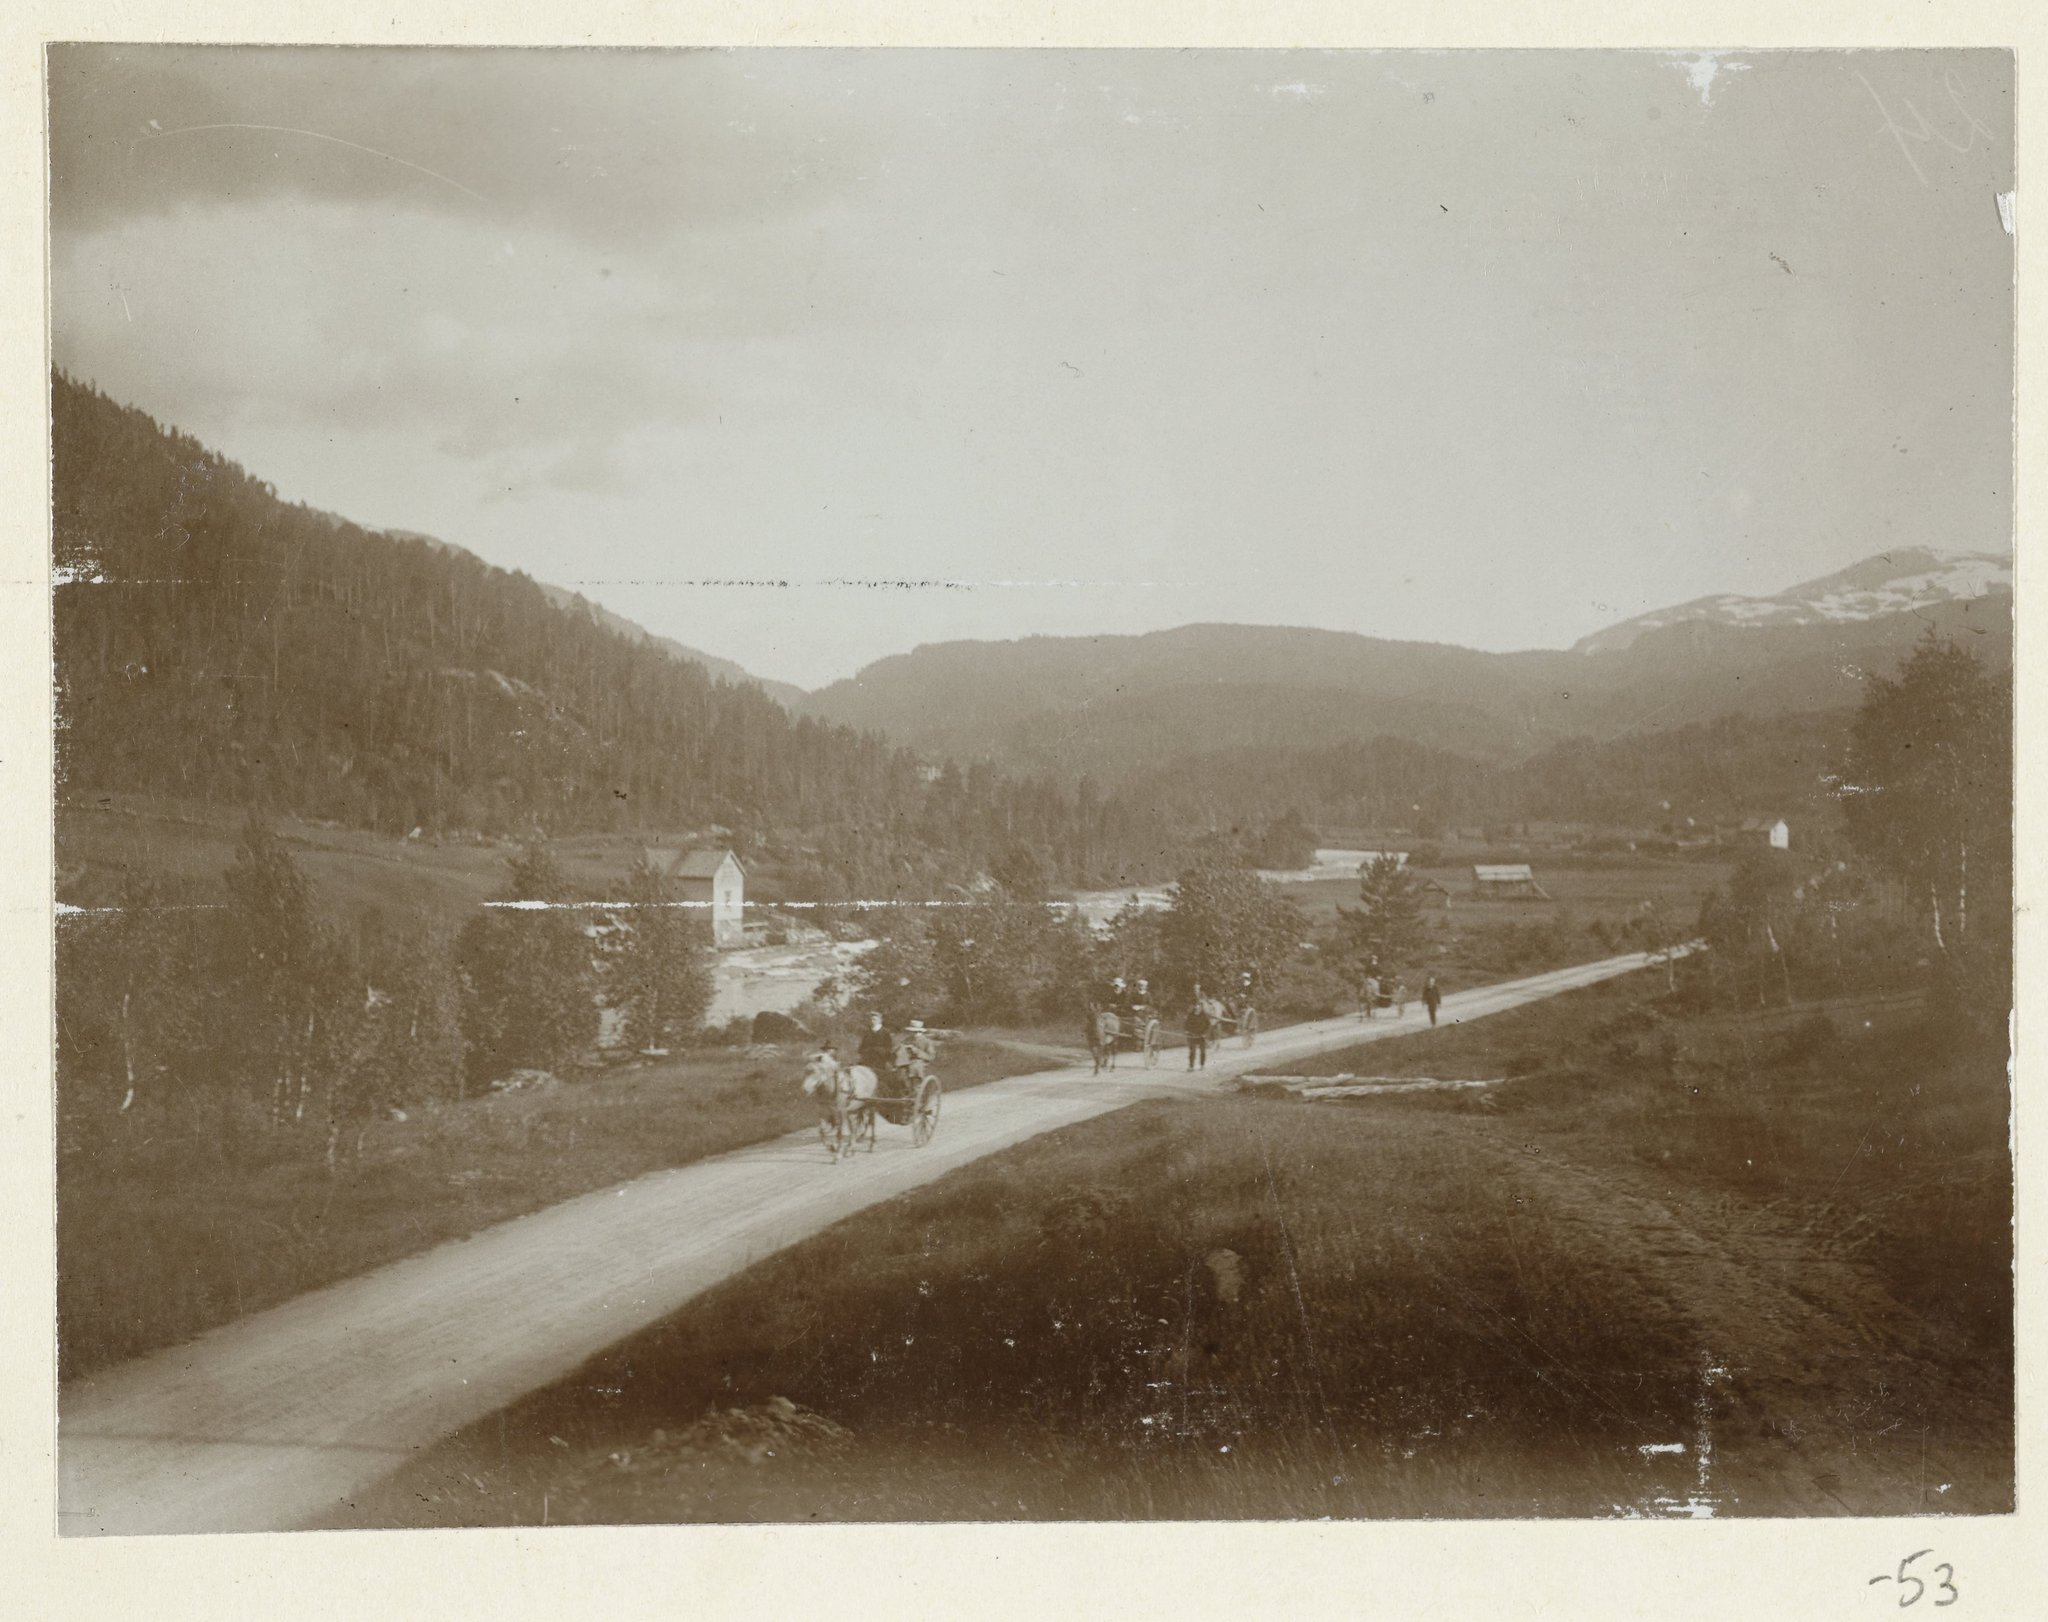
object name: photograph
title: Een tocht met rijtuigen en paarden door een glooiend dal, vermoedelijk in de Harz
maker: geldolph adriaan kessler (dolph)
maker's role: fotograaf, industrieel, voetballer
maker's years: 1884-1945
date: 1903-1908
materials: cardboard, photographic support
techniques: gelatin silver print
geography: harz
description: Een tocht met rijtuigen en paarden door een glooiend dal, vermoedelijk in de HarzOnderdeel van het fotoalbum van Dolph Kessler met opnamen die hij maakte tijdens zijn verblijf in Engeland en op een wereldreis die hij als secretaris van Henri Deterding (directeur Koninklijke Olie) ondernam naar Nederlands-Indië, Japan, China en de Verenigde Staten, tussen 1906 en 1908.